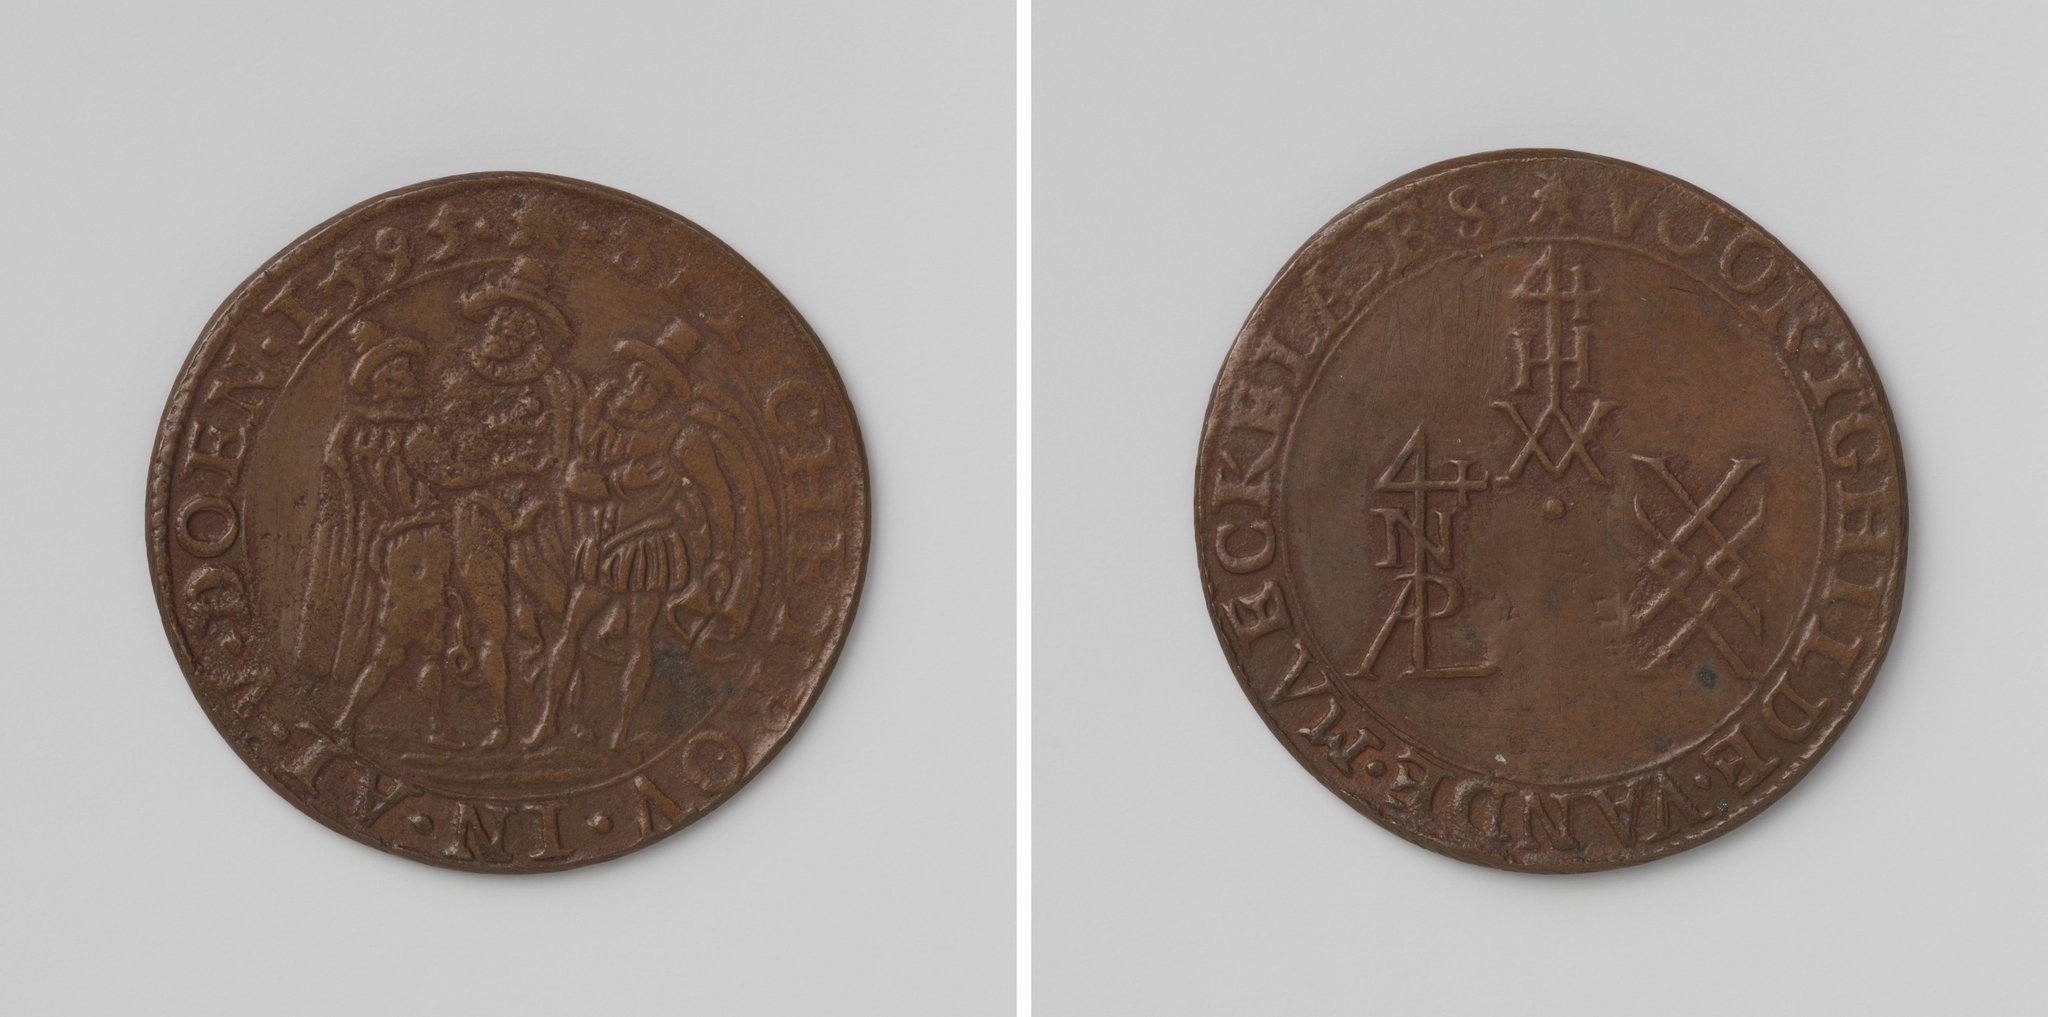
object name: medal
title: Makelaarsgilde van Middelburg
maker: Anonymous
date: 1595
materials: copper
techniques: striking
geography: middelburg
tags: middelburg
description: Koperen penning. Voorzijde: drie mannen die met elkaar staan te praten binnen omschrift. Keerzijde: drie huismerken; gildenummer daartussen is uitgekrast